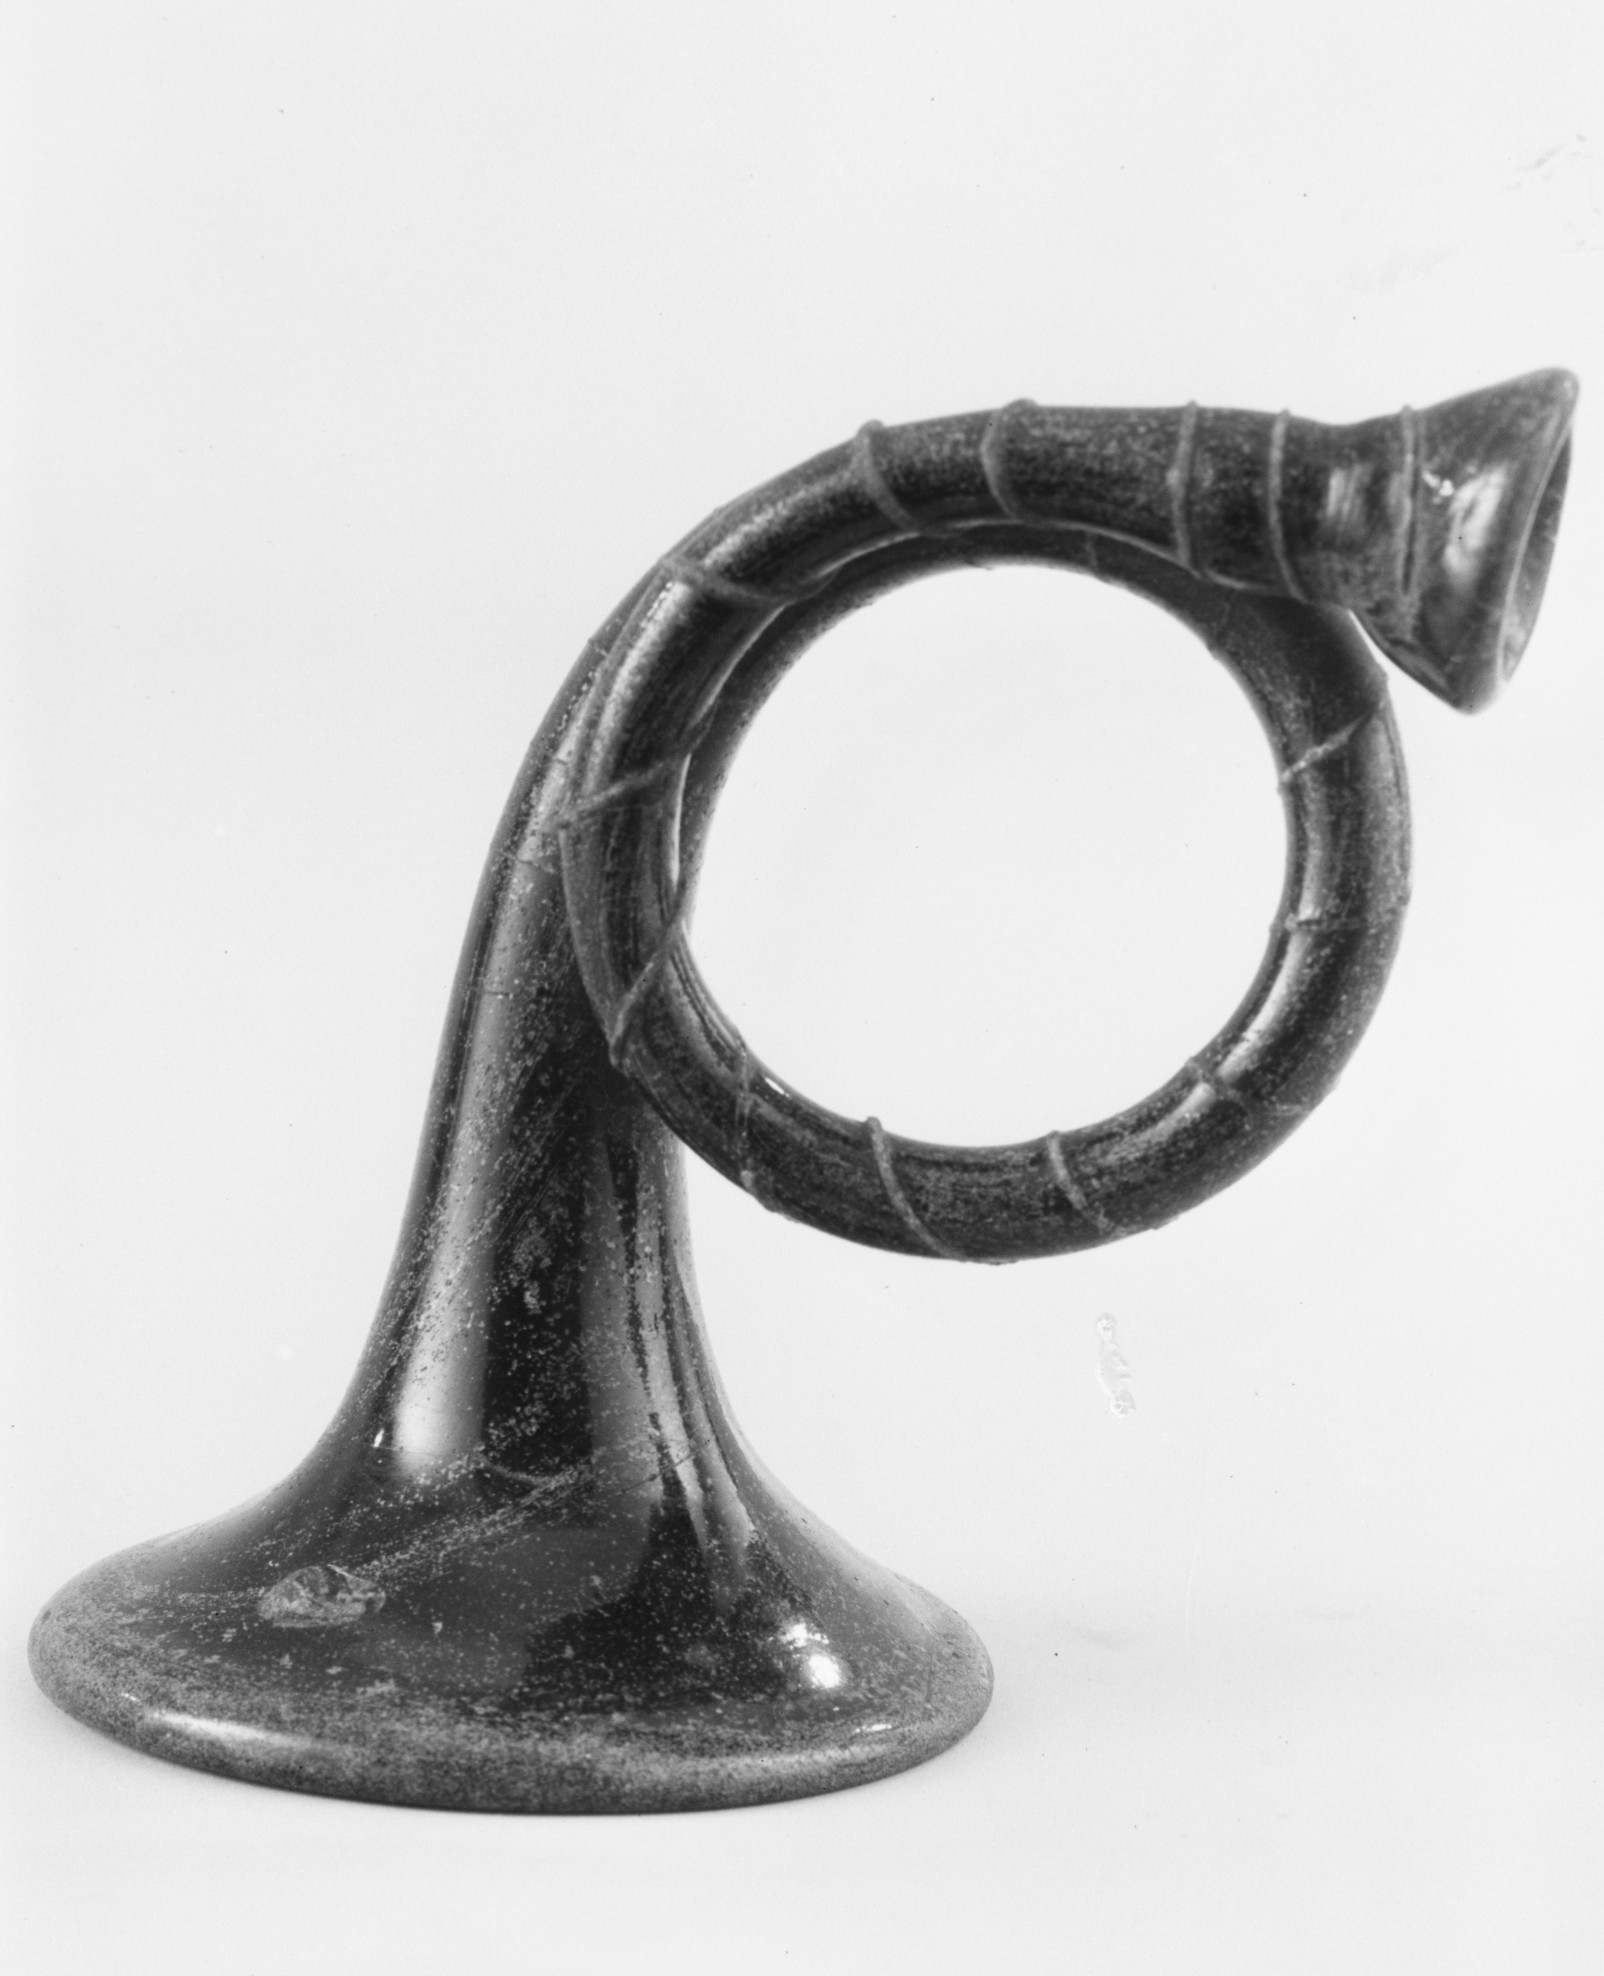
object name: horn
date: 1601-1700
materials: glass